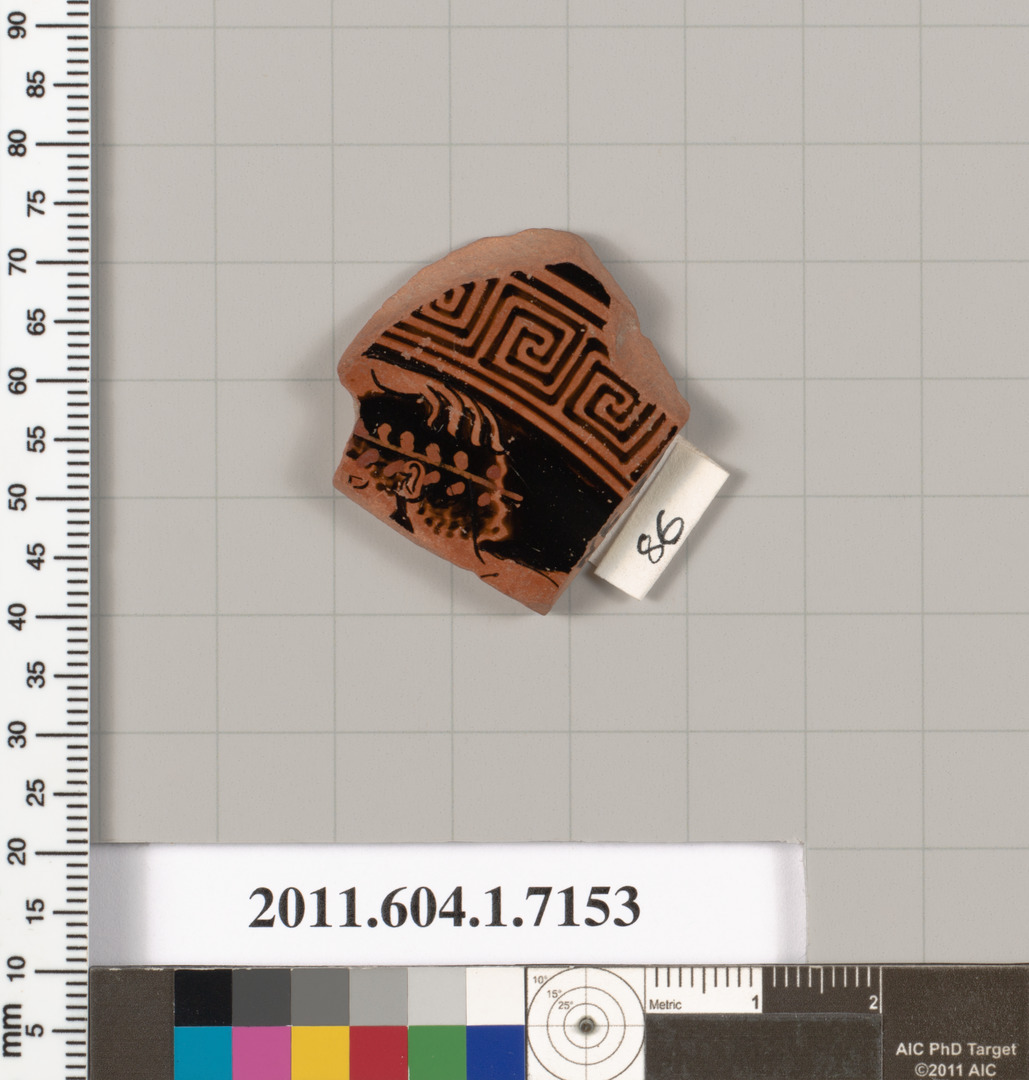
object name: kylix fragment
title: Terracotta fragment of a kylix (drinking cup)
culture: greek, attic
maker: makron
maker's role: artist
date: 500-480 BCE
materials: terracotta